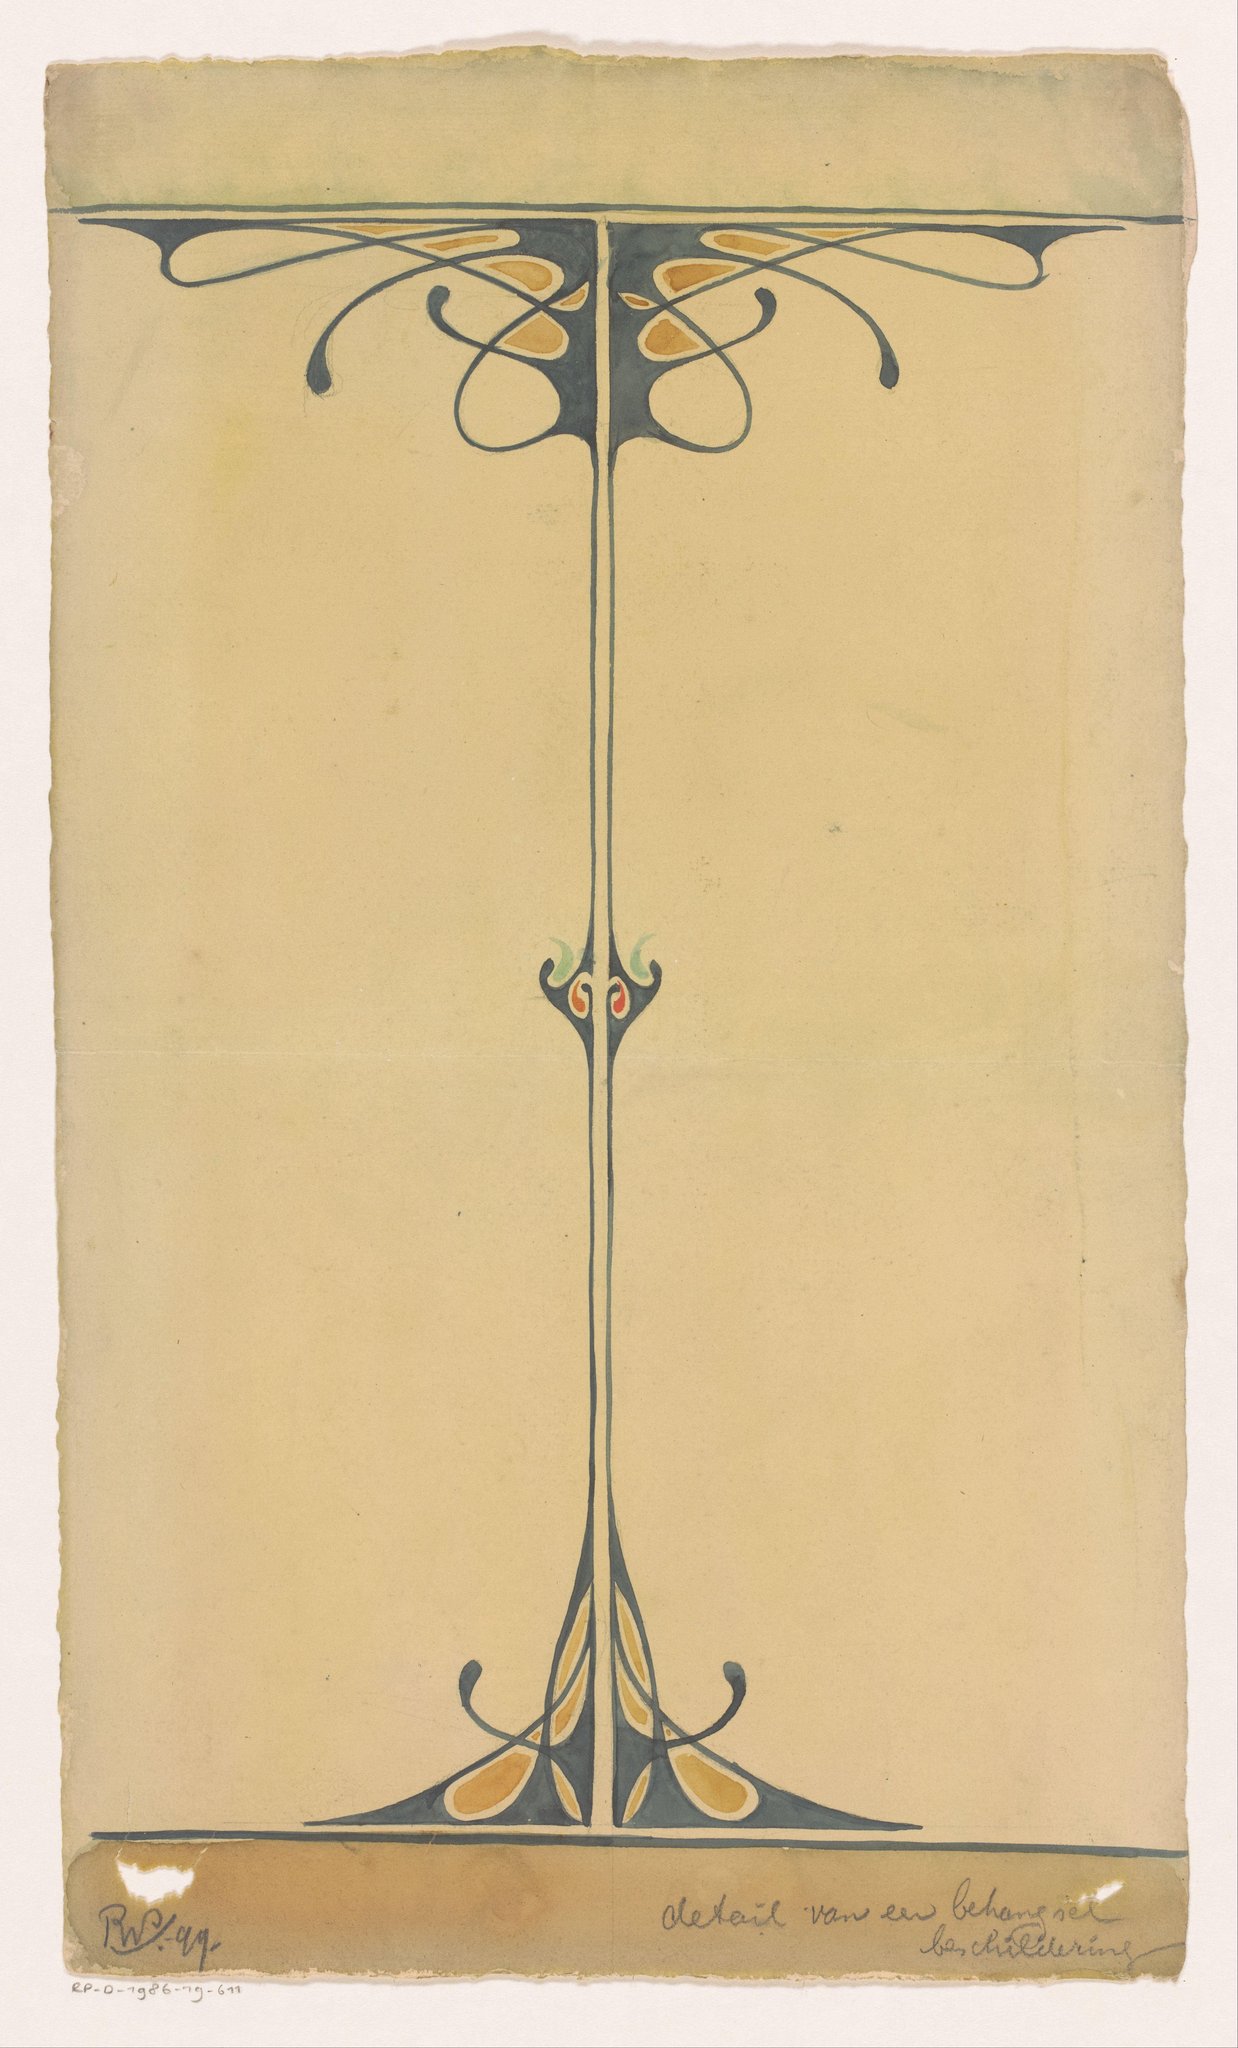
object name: drawing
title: Ontwerp voor een behangsel met ornament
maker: reinier willem petrus de vries (1874-1953)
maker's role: draughtsman, print maker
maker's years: 1874-1953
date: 1899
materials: paper, pencil, watercolor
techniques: brush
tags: ornaments ~ art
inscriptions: collector's mark: ‘R:MVS.’, annotation: ‘detail van een behangsel/ beschildering’